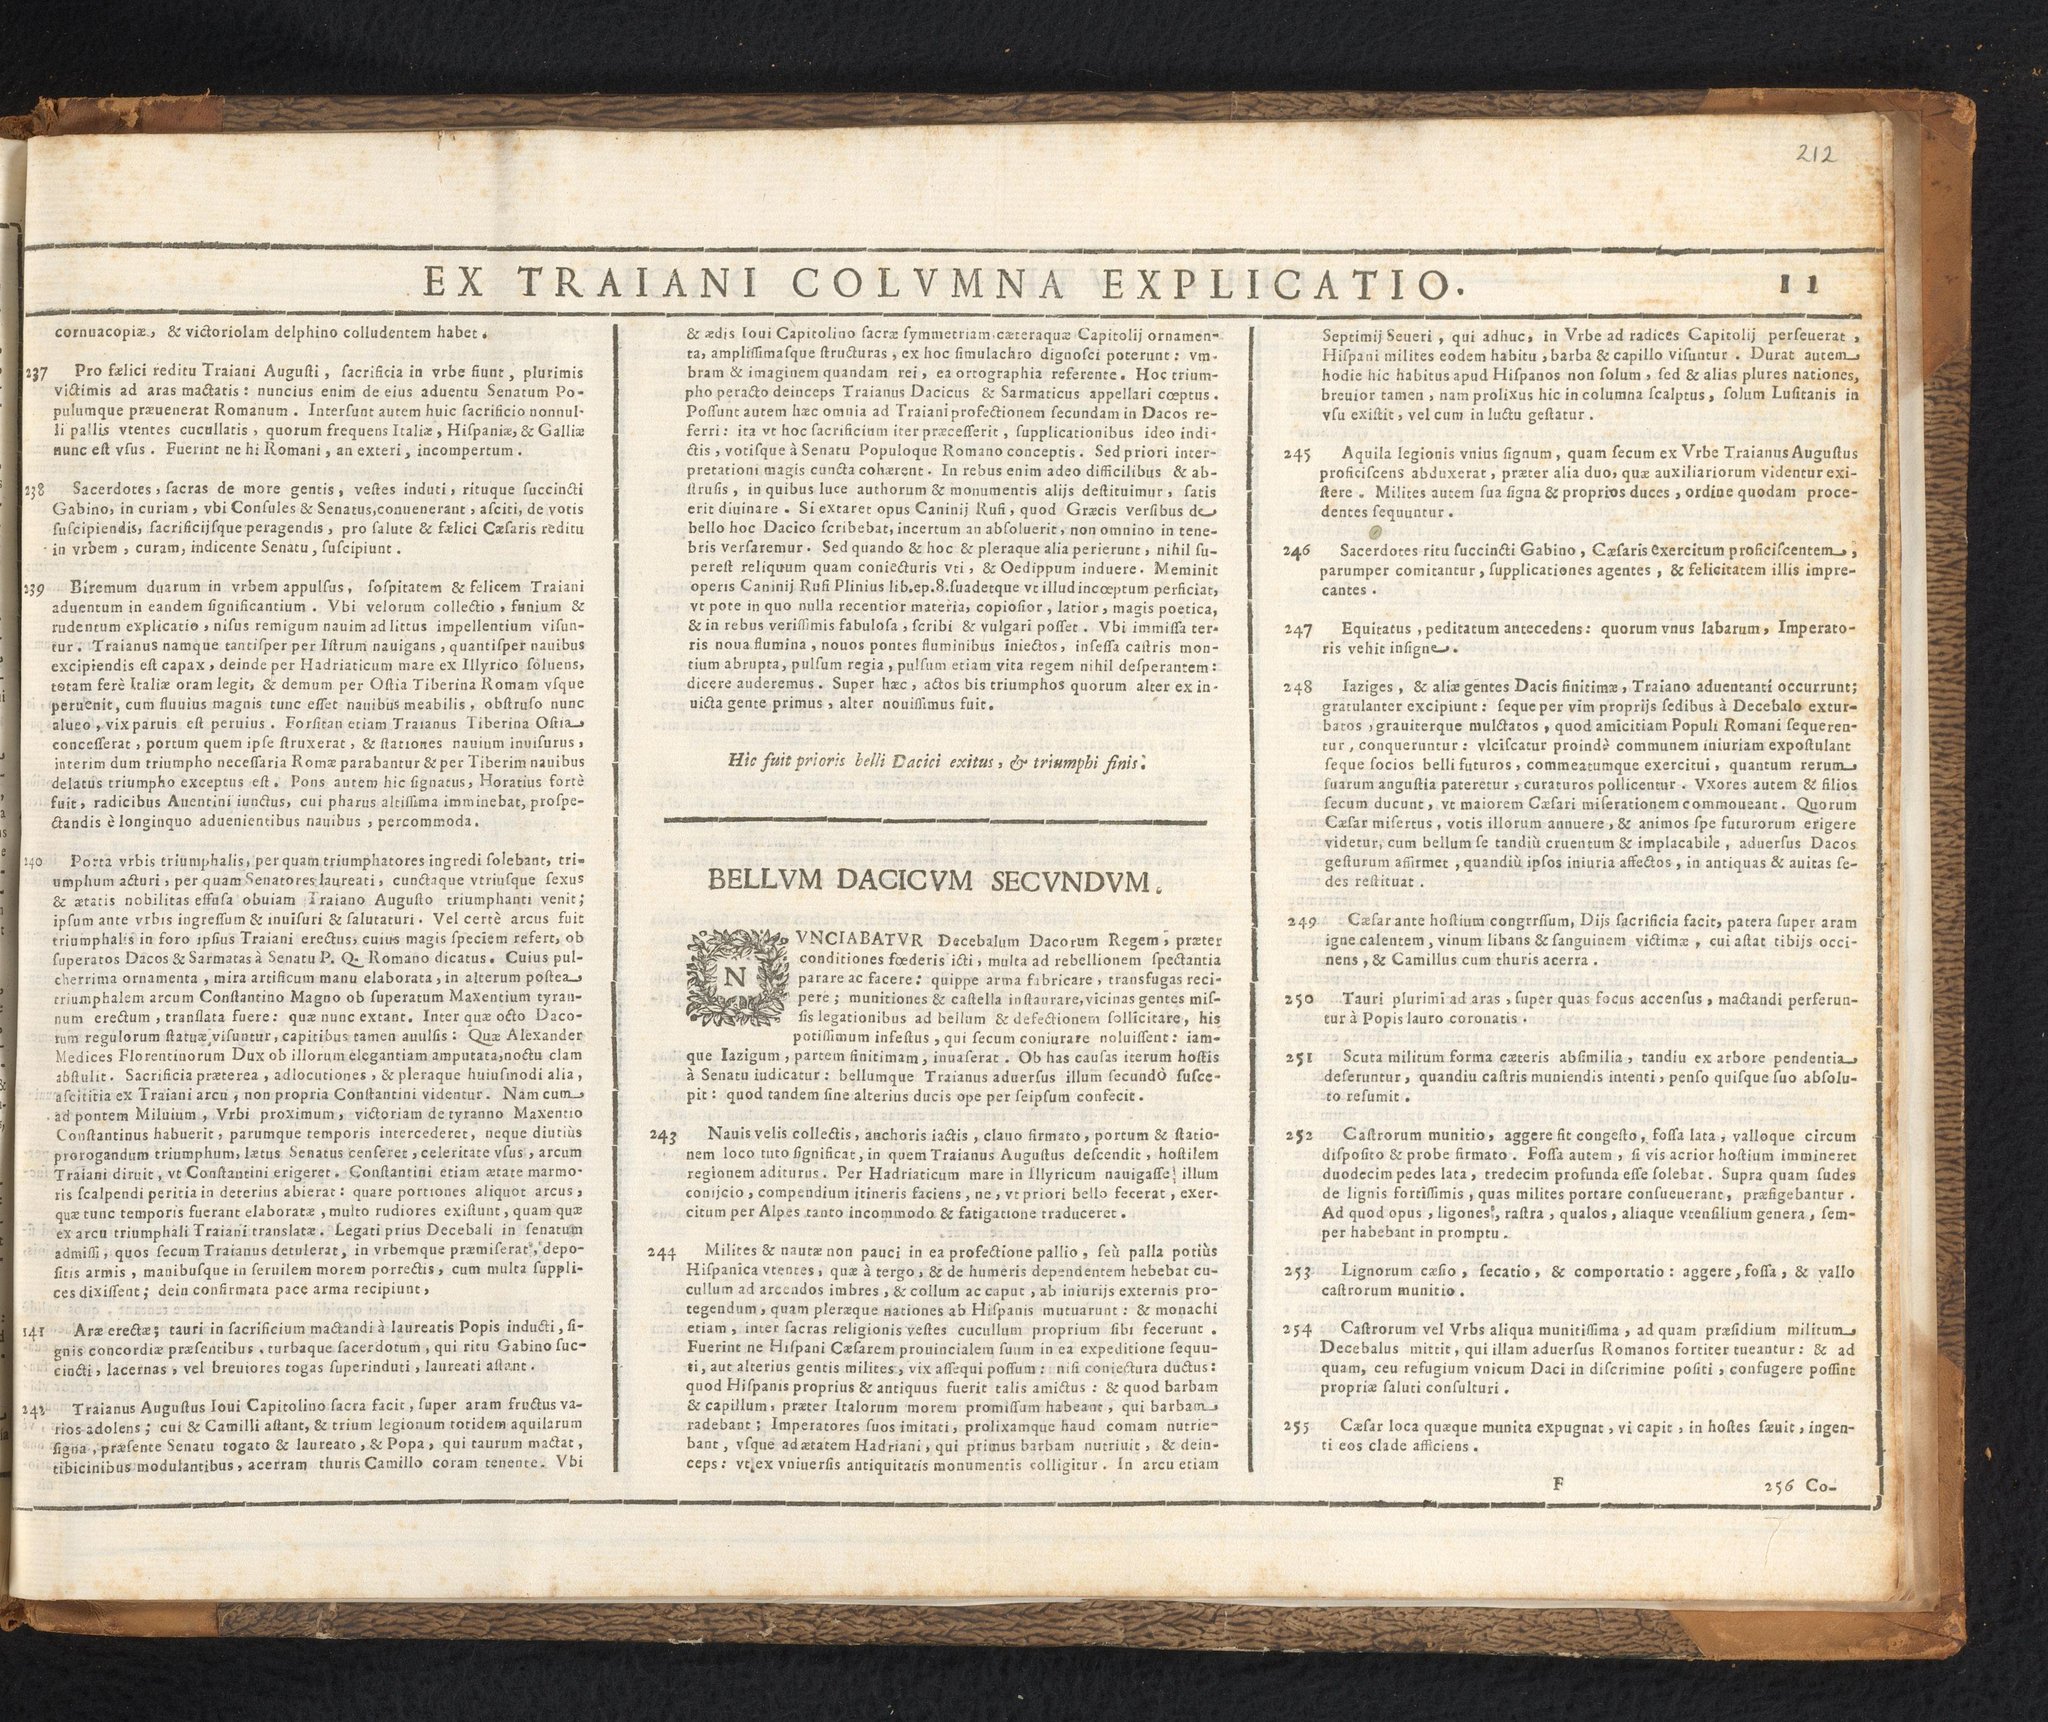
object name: album leaf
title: Historia utriusque belli dacici a Traiano Caesare gest (...)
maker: Anonymous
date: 1550-1599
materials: paper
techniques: letterpress printing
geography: rome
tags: zuil van trajanus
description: Een beschrijving van scènes 237 tot en met 255 op de Zuil van Trajanus, in het Italiaans. Prent maakt deel uit van een album.